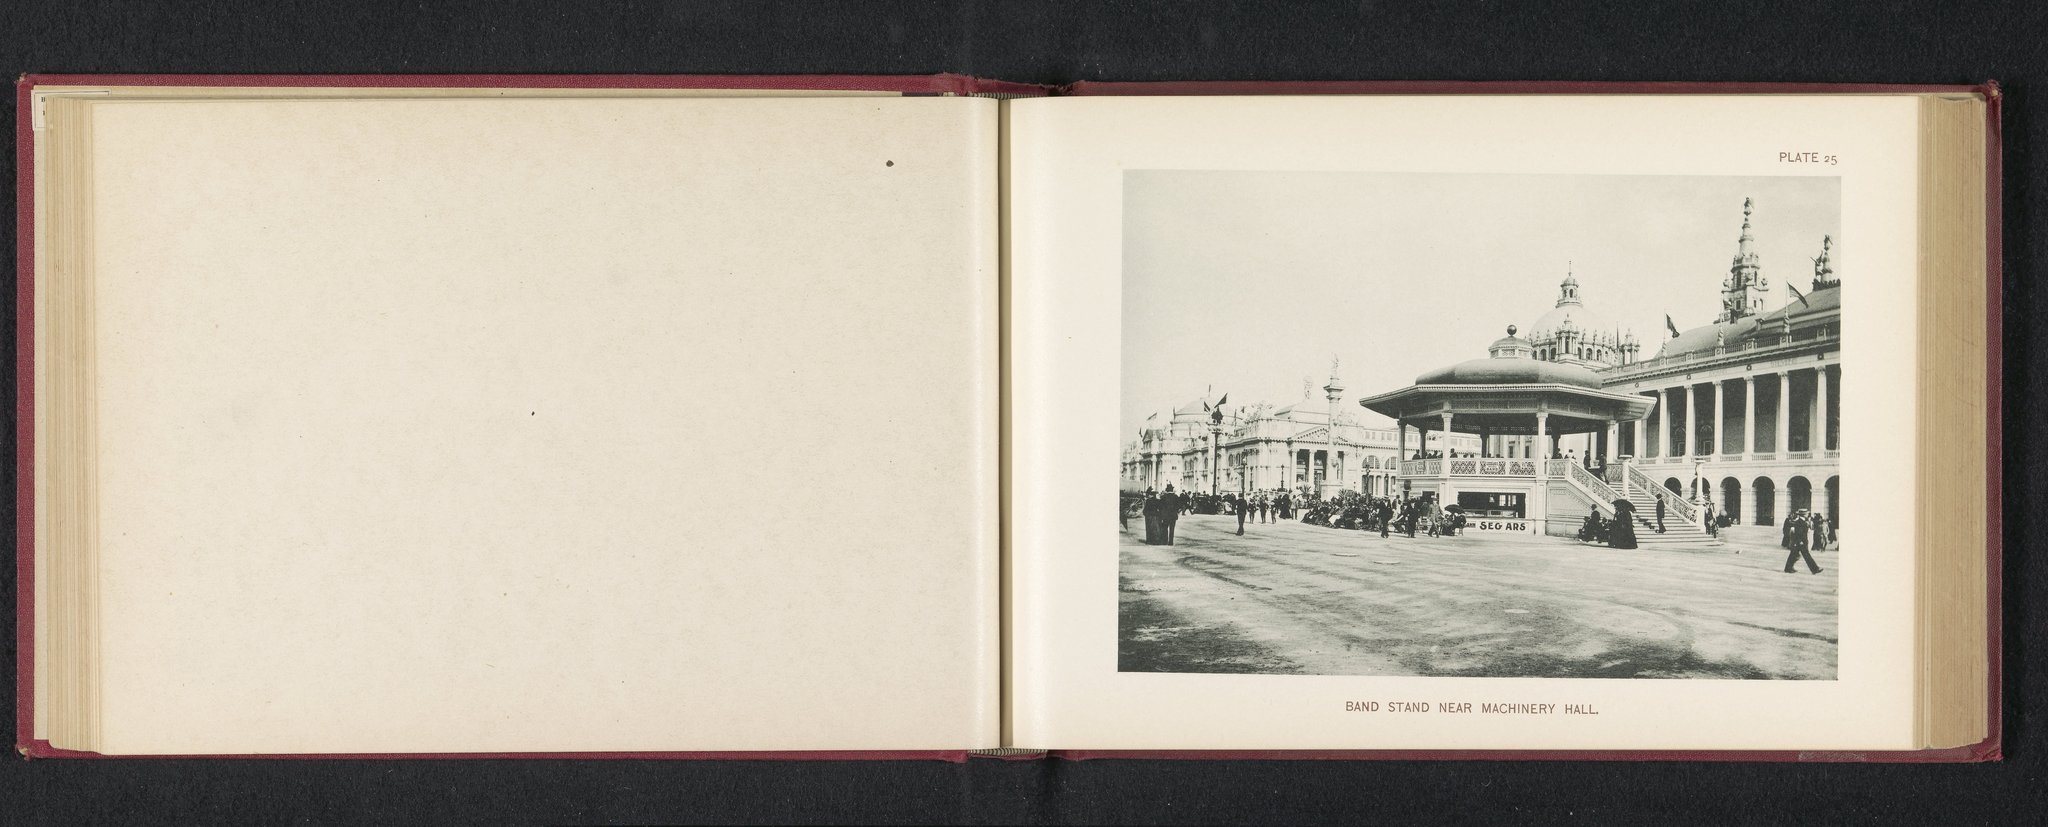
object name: photomechanical print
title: Band stand near Machinery Hall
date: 1893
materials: paper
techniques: photograph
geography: chicago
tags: world fair, world exhibition, music-hall - aa - open-air performances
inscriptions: number: ‘Plate 25’